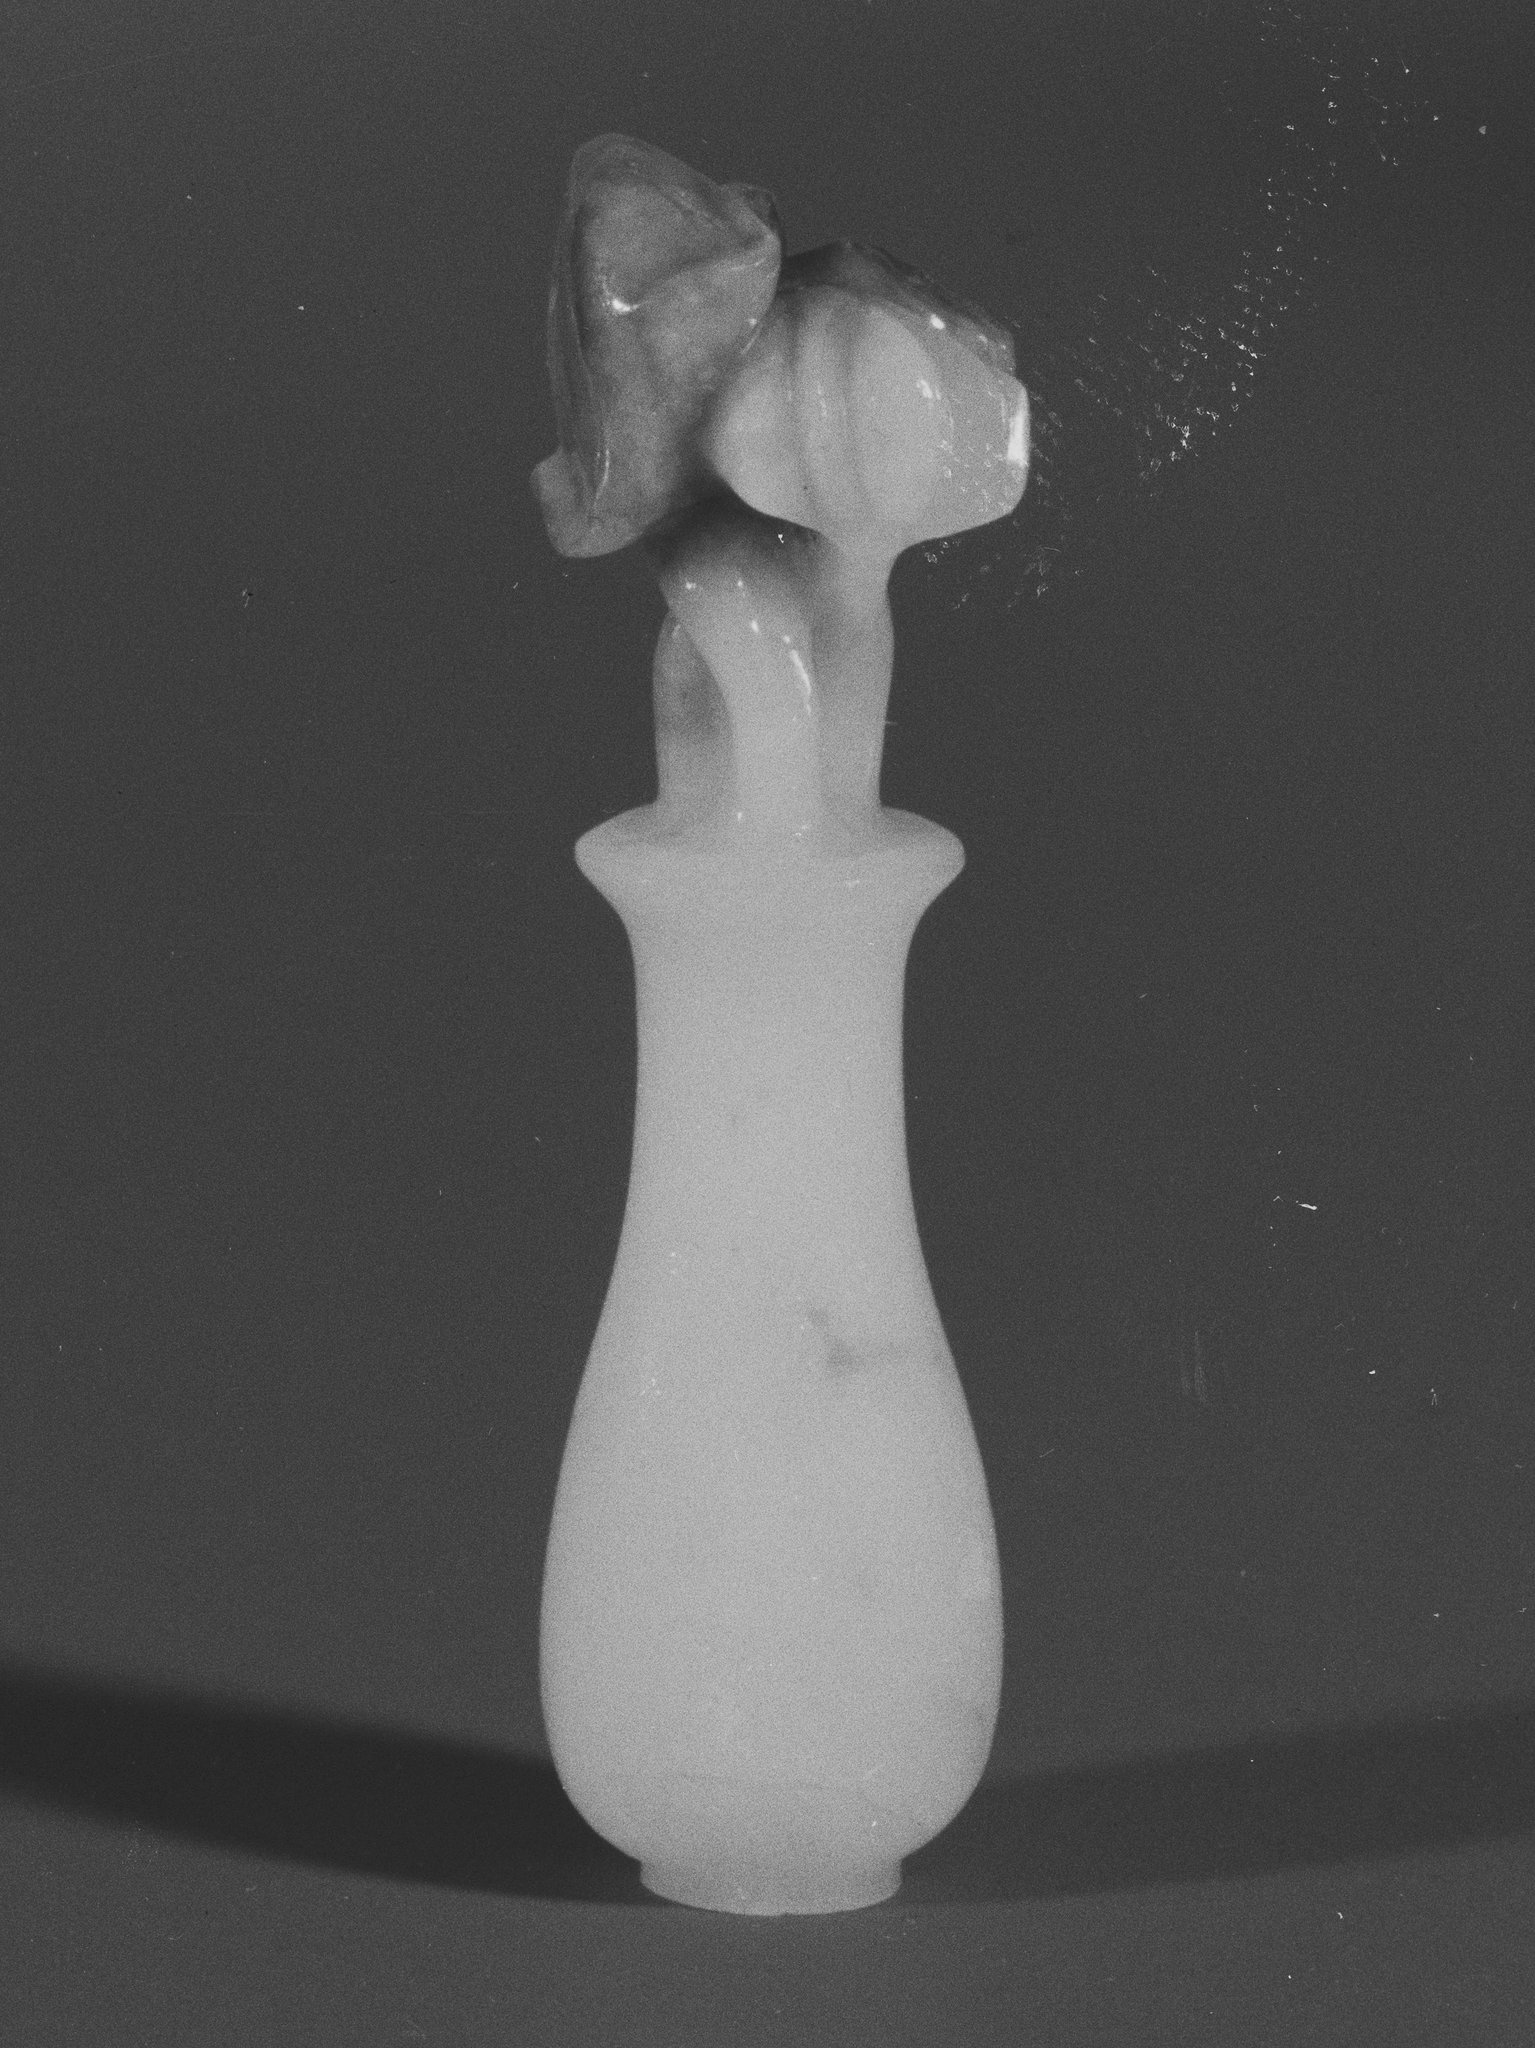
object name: vase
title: Miniature Vase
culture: chinese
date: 1901-2000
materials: jade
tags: flowers